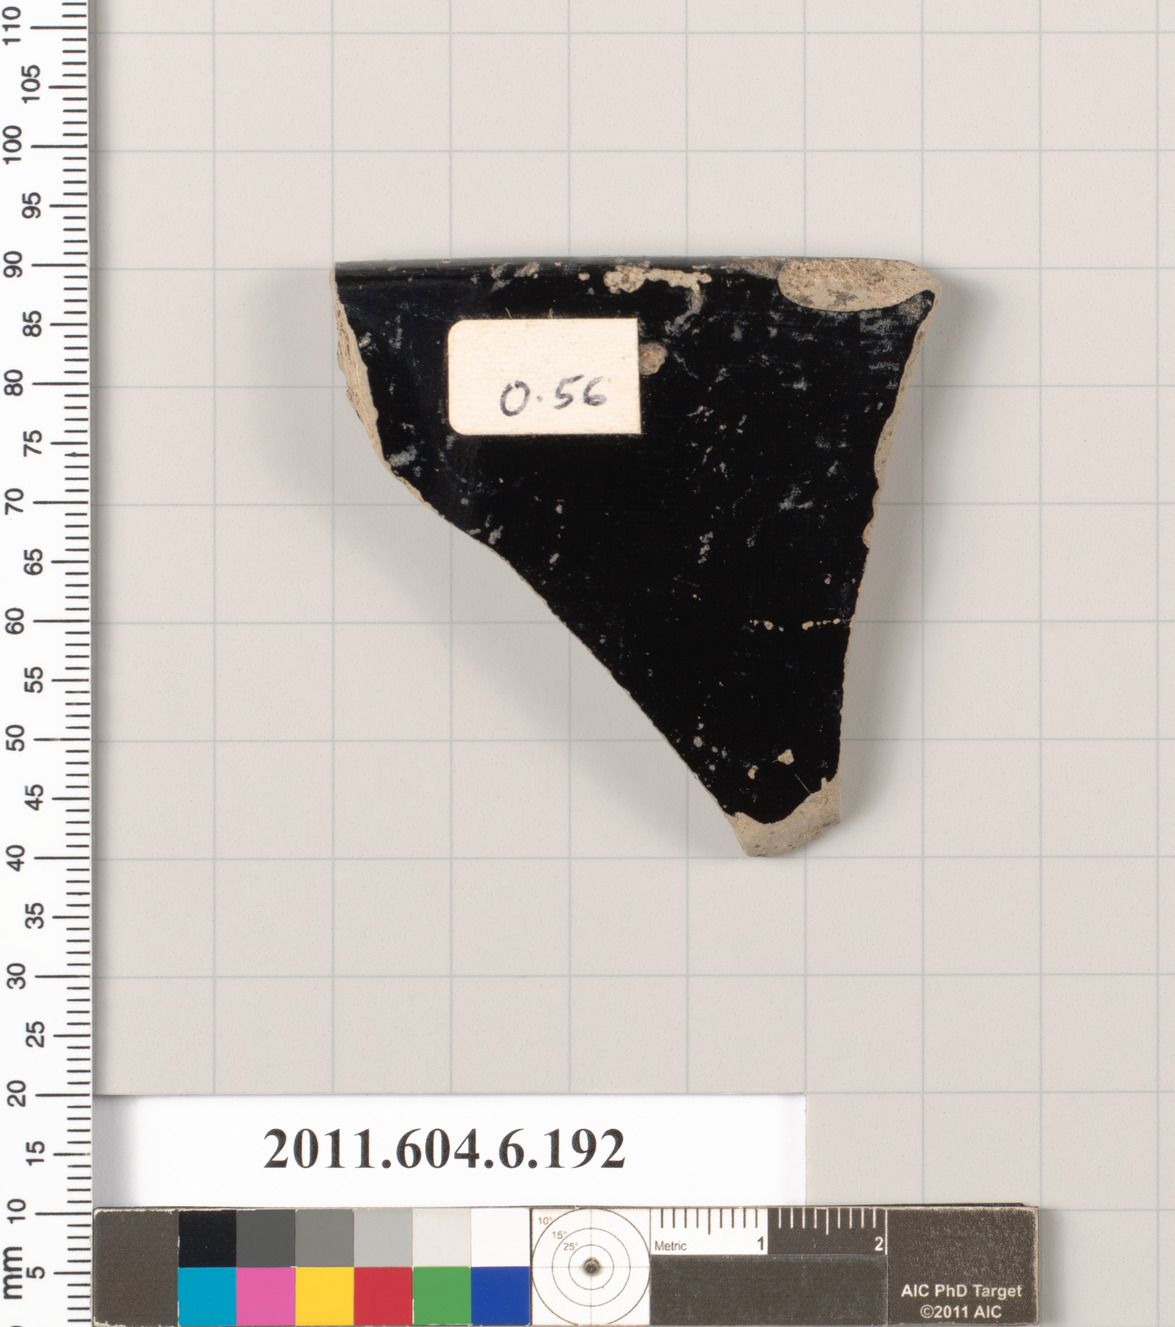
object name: skyphos fragment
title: Terracotta rim fragment of a skyphos (deep drinking cup)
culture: greek, attic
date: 500-401 BCE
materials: terracotta